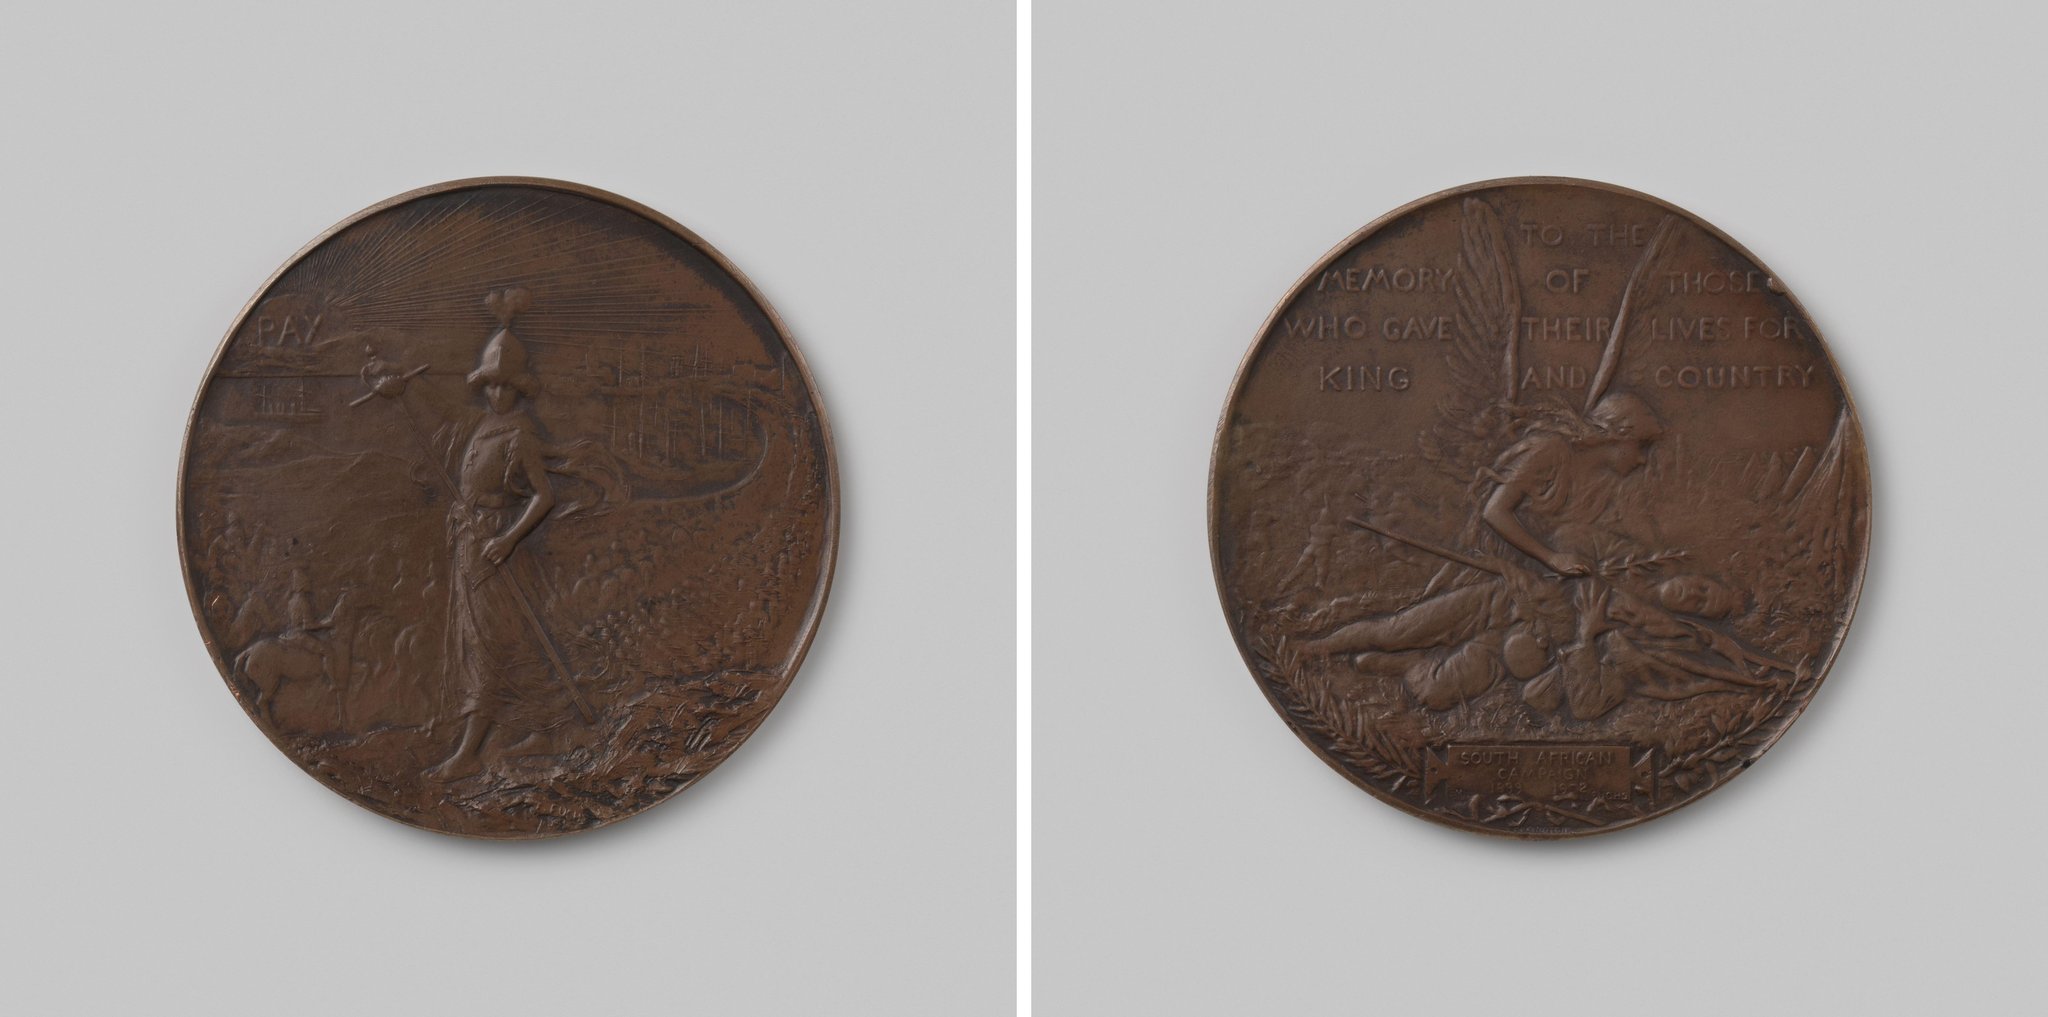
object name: honorary medal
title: Boerenoorlog, penning geslagen ter ere van degenen die hun leven gaven voor koning en vaderland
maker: emil fuchs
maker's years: 1866-1909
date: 1902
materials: bronze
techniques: striking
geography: london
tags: zuid-afrika, tweede boerenoorlog (1899-1902)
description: Commemorative medal for British victims of the Boer War. Bronze, E. Fuchs, 1902. The Boer War fanned nationalist feeling in Britain to new heights, too. The whole country was united in its support of a war in which 250,000 British soldiers fought in South Africa. This medal was struck in Britain after the war had been won, to commemorate the thousands of British casualties. The obverse shows a soldier with plumed helmet sheathing his sword. He symbolizes peace. On the reverse an angel holding a laurel branch kneels beside a fallen soldier. The text on the reverse reads: 'Who gave their lives for Queen and Country'. Below is the text: 'South Africa campaign 1899-1902'.